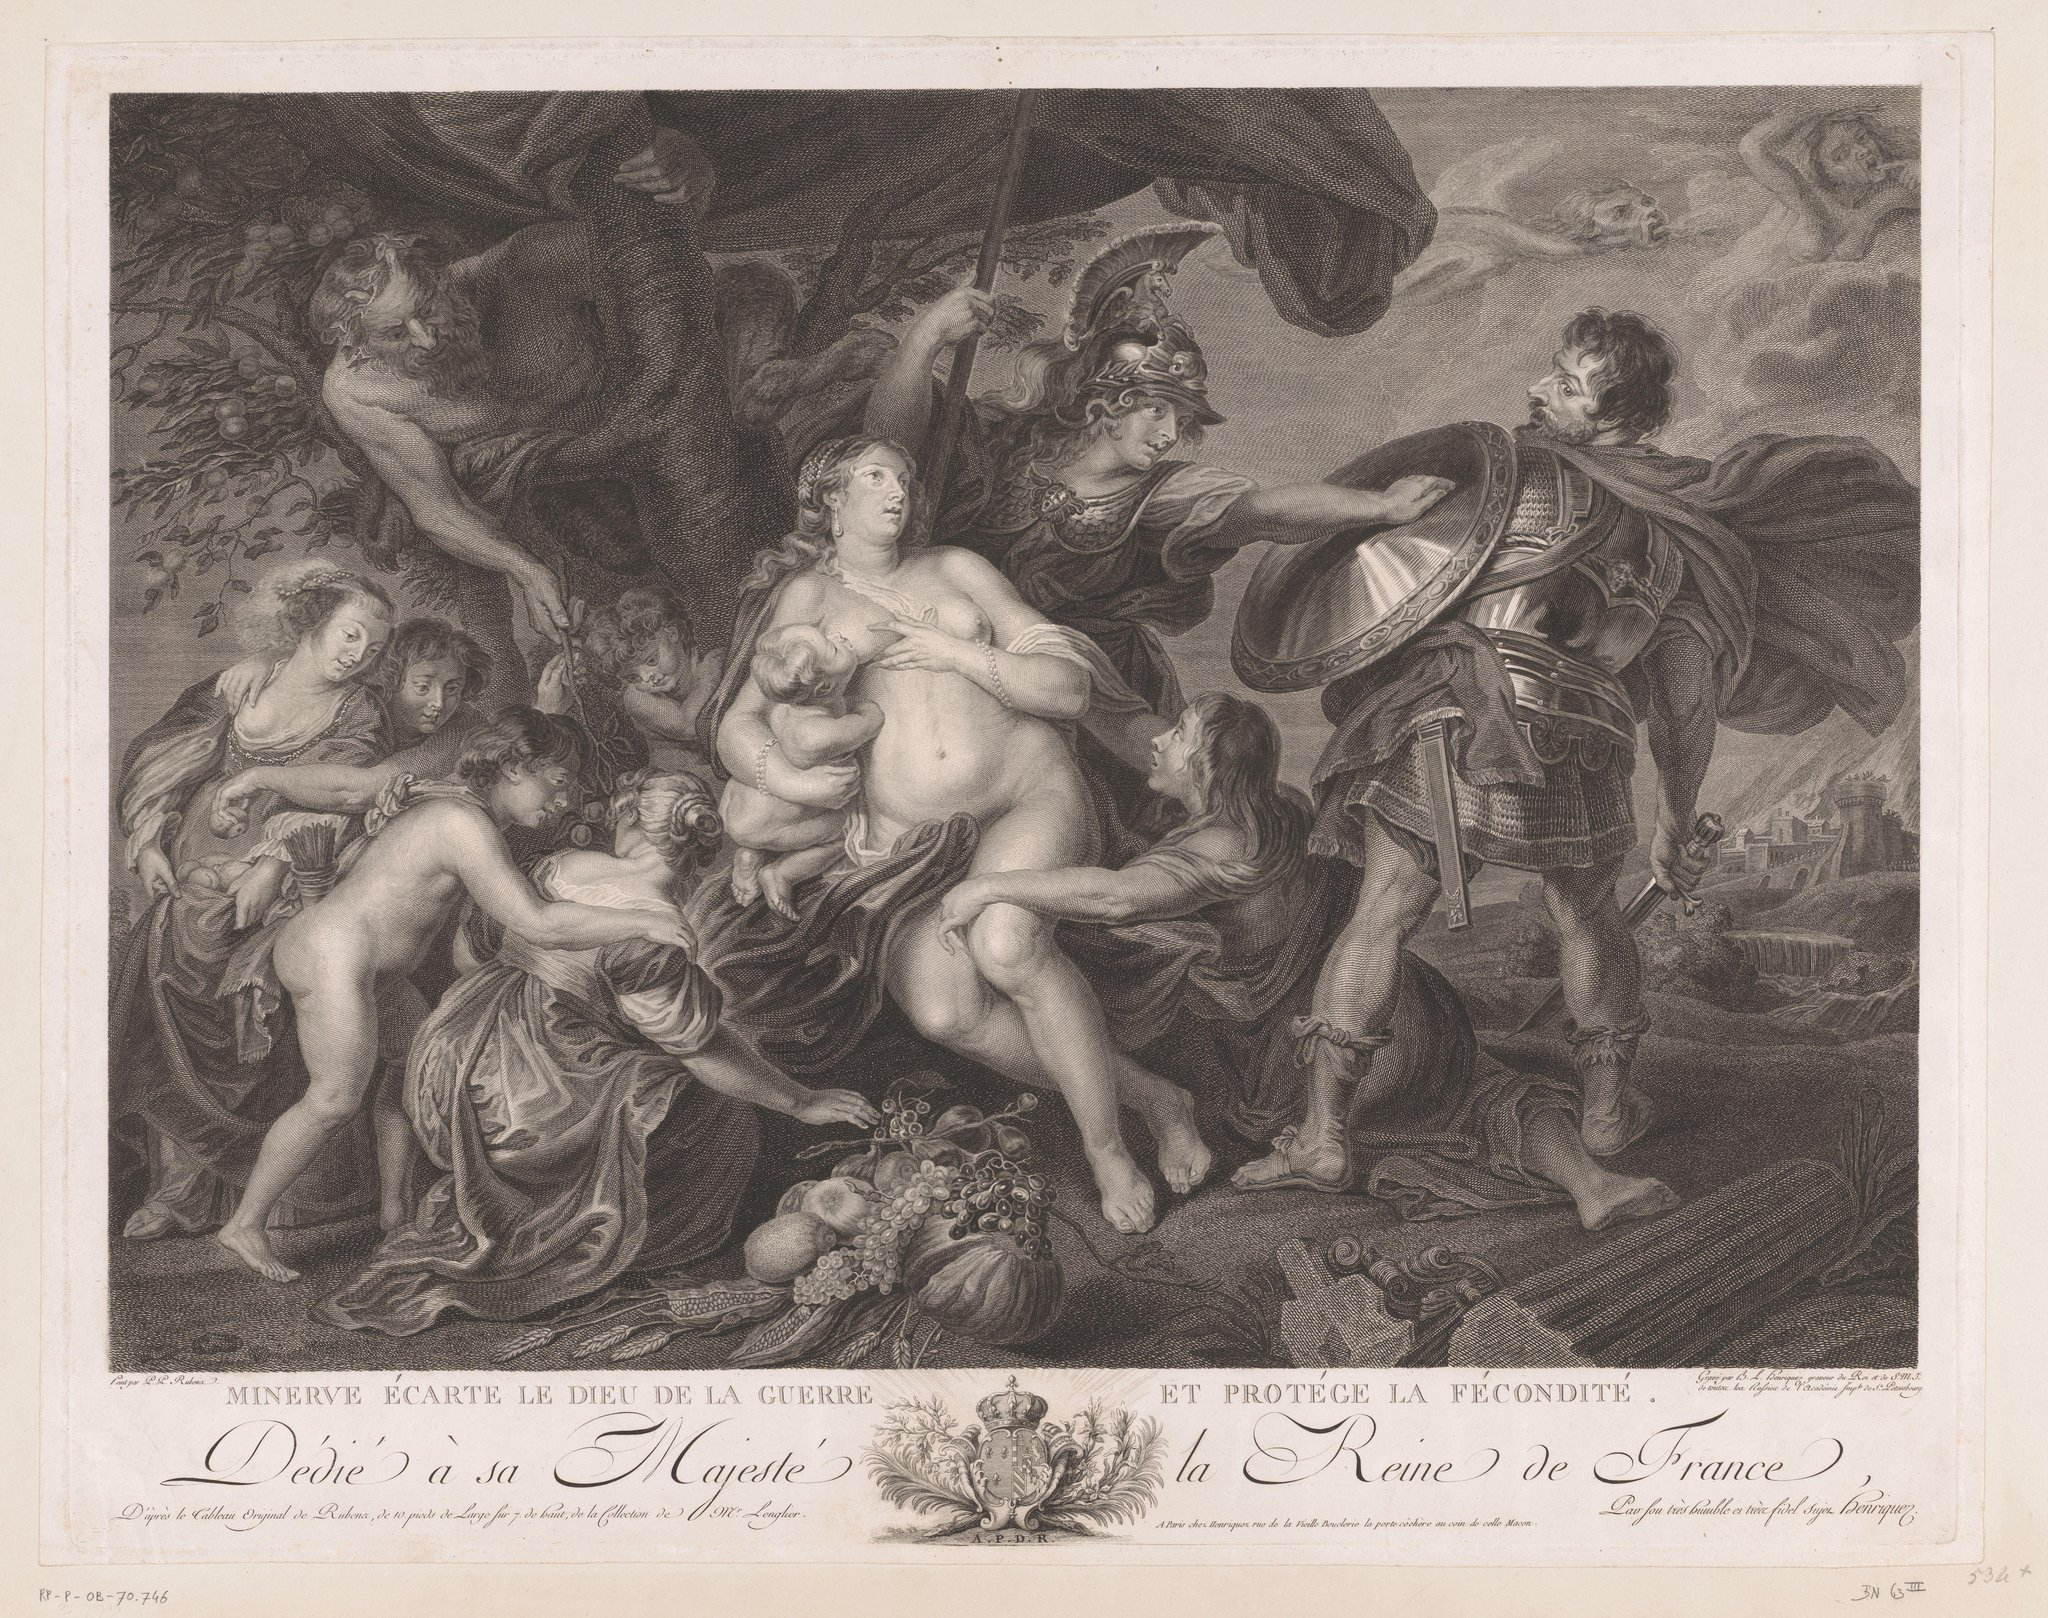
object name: print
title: Minerve écarte le dieu de la guerre et protége la fécondité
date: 1782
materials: paper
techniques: engraving, etching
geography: paris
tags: (story of) mars (ares), war and peace, (story of) minerva (pallas, athena), fruitfulness, productiveness, fertility, fecundity; 'fecondità' (ripa)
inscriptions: collector's mark: Lugt 240, inscription: ‘f 2150-’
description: Het schilderij bevindt zich in de Alte Pinakothek te München.